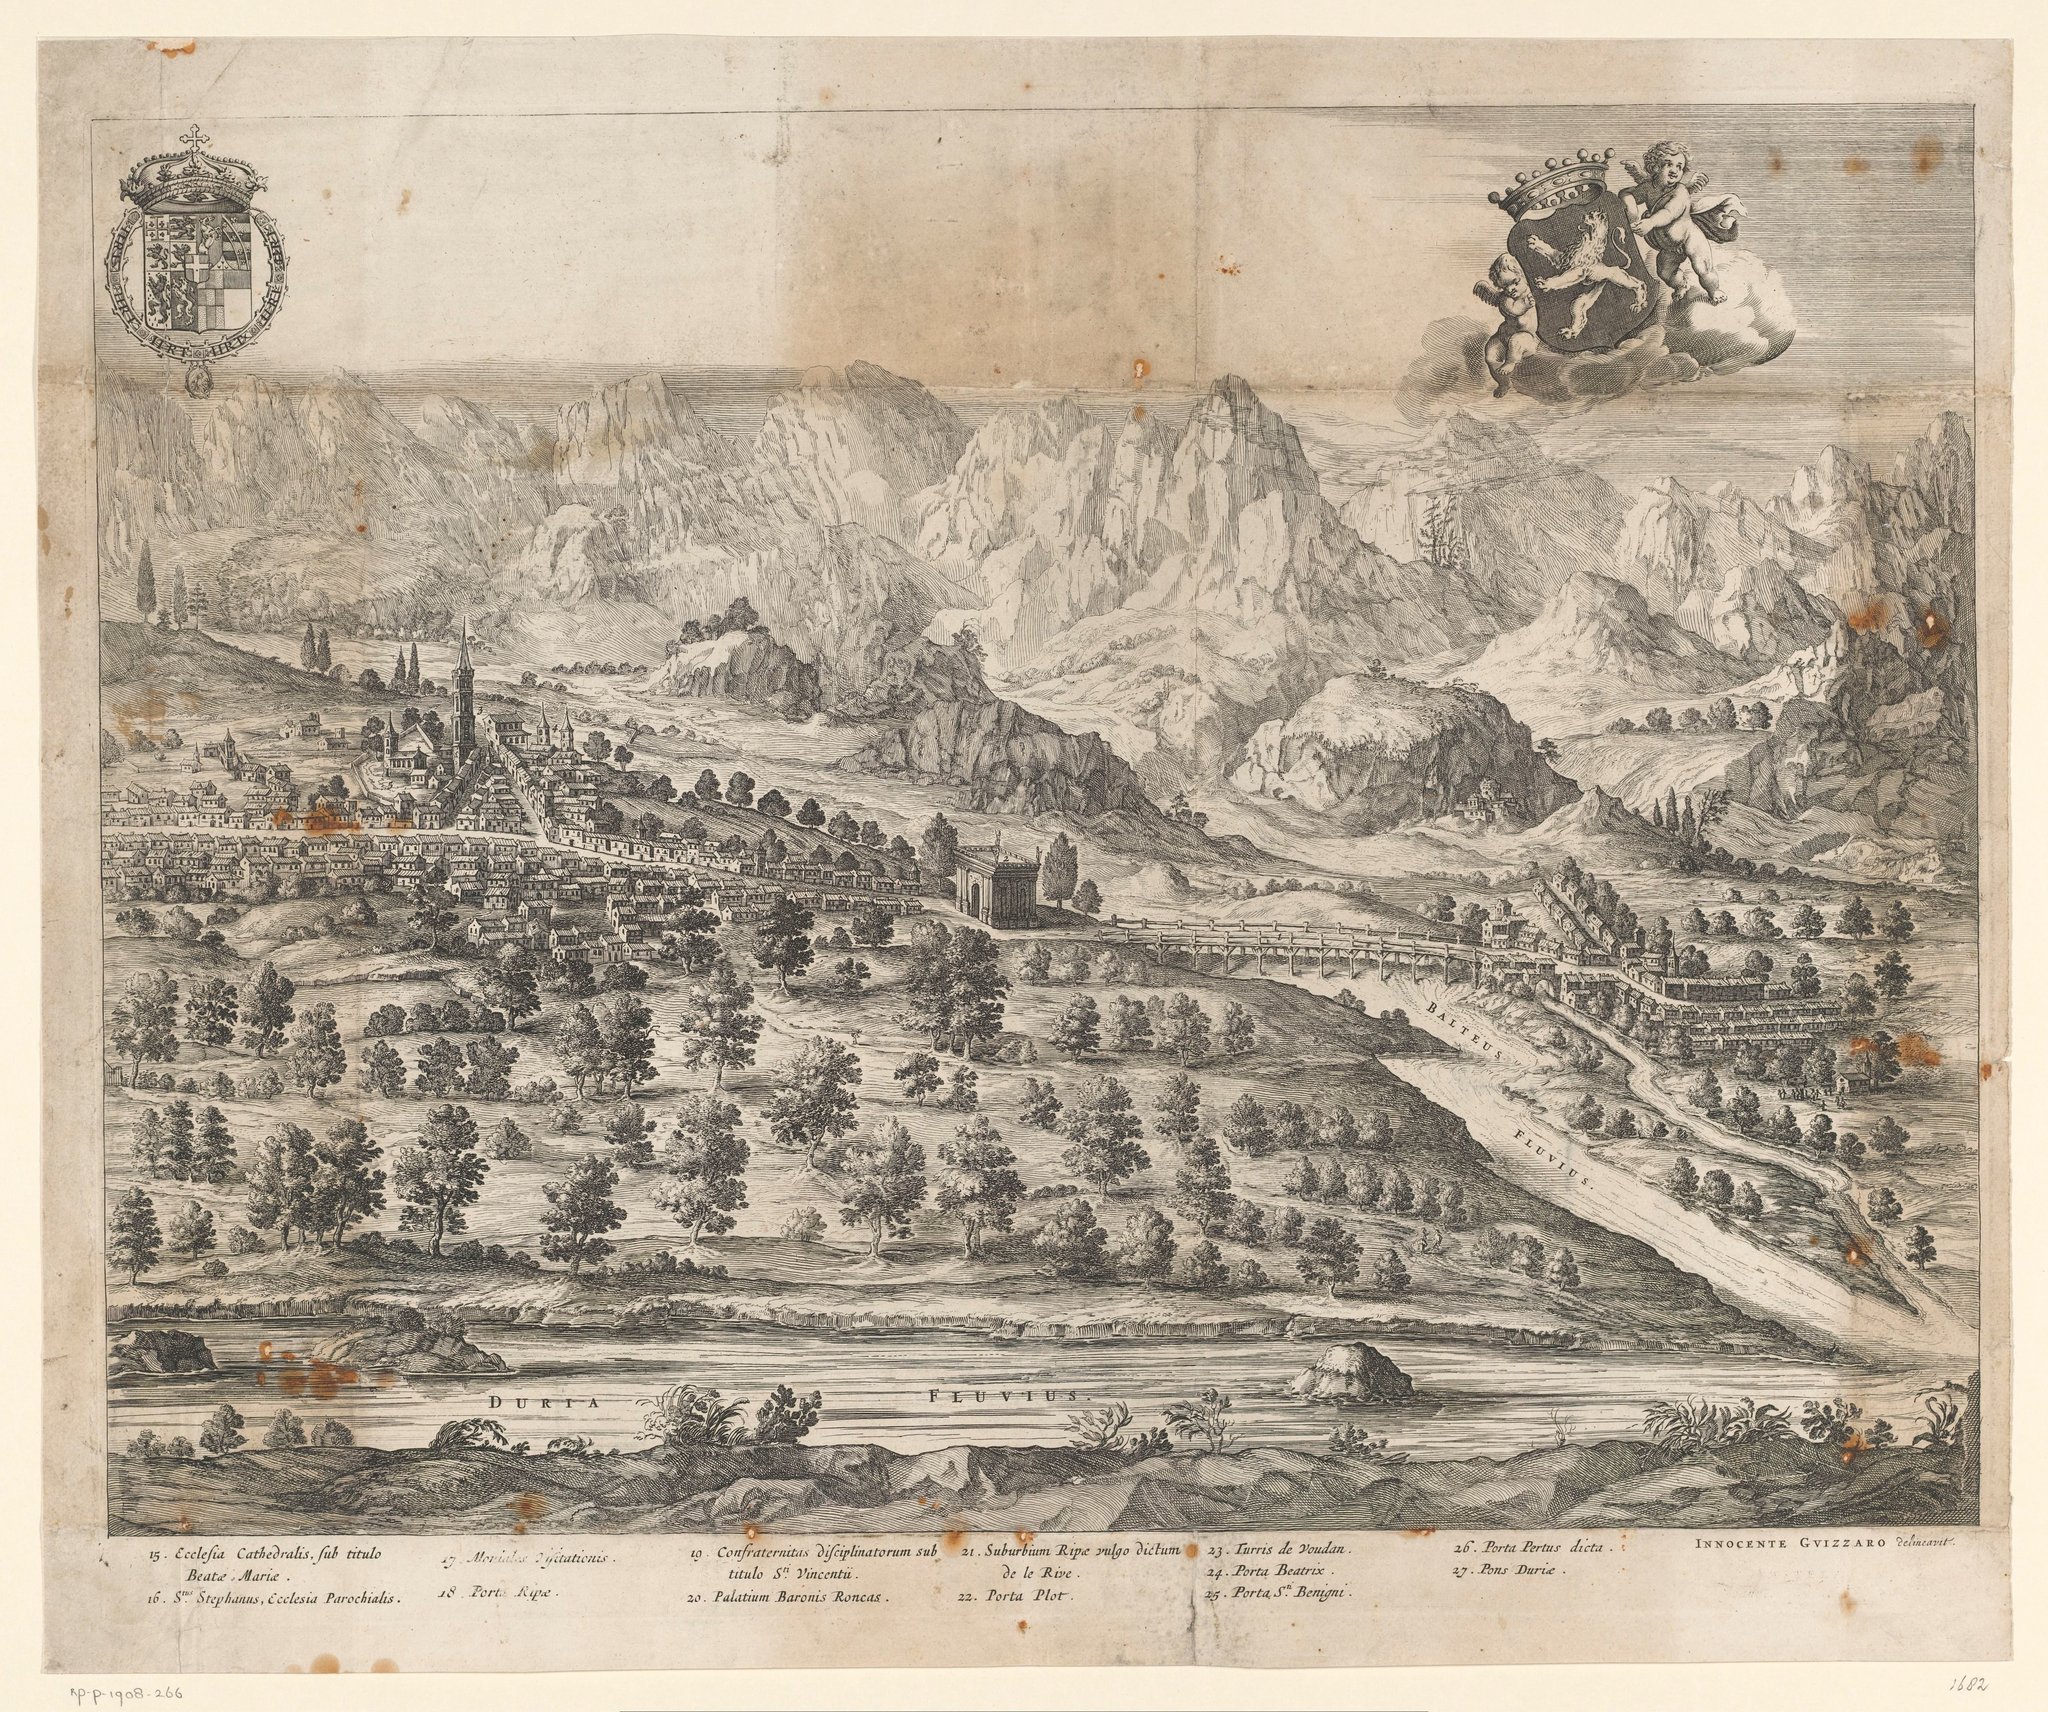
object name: print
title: Rechterdeel van een gezicht op Aosta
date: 1682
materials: paper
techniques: engraving, etching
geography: the hague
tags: coat of arms (as symbol of the state, etc.) (+ city; municipal), prospect of city, town panorama, silhouette of city, armorial bearing, heraldry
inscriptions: collector's mark: Lugt 2228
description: Rechterdeel van een gezicht op Aosta, bestaande uit twee delen. Linksboven het wapen van de hertog van Savoye, rechtsboven het wapen van de stad.